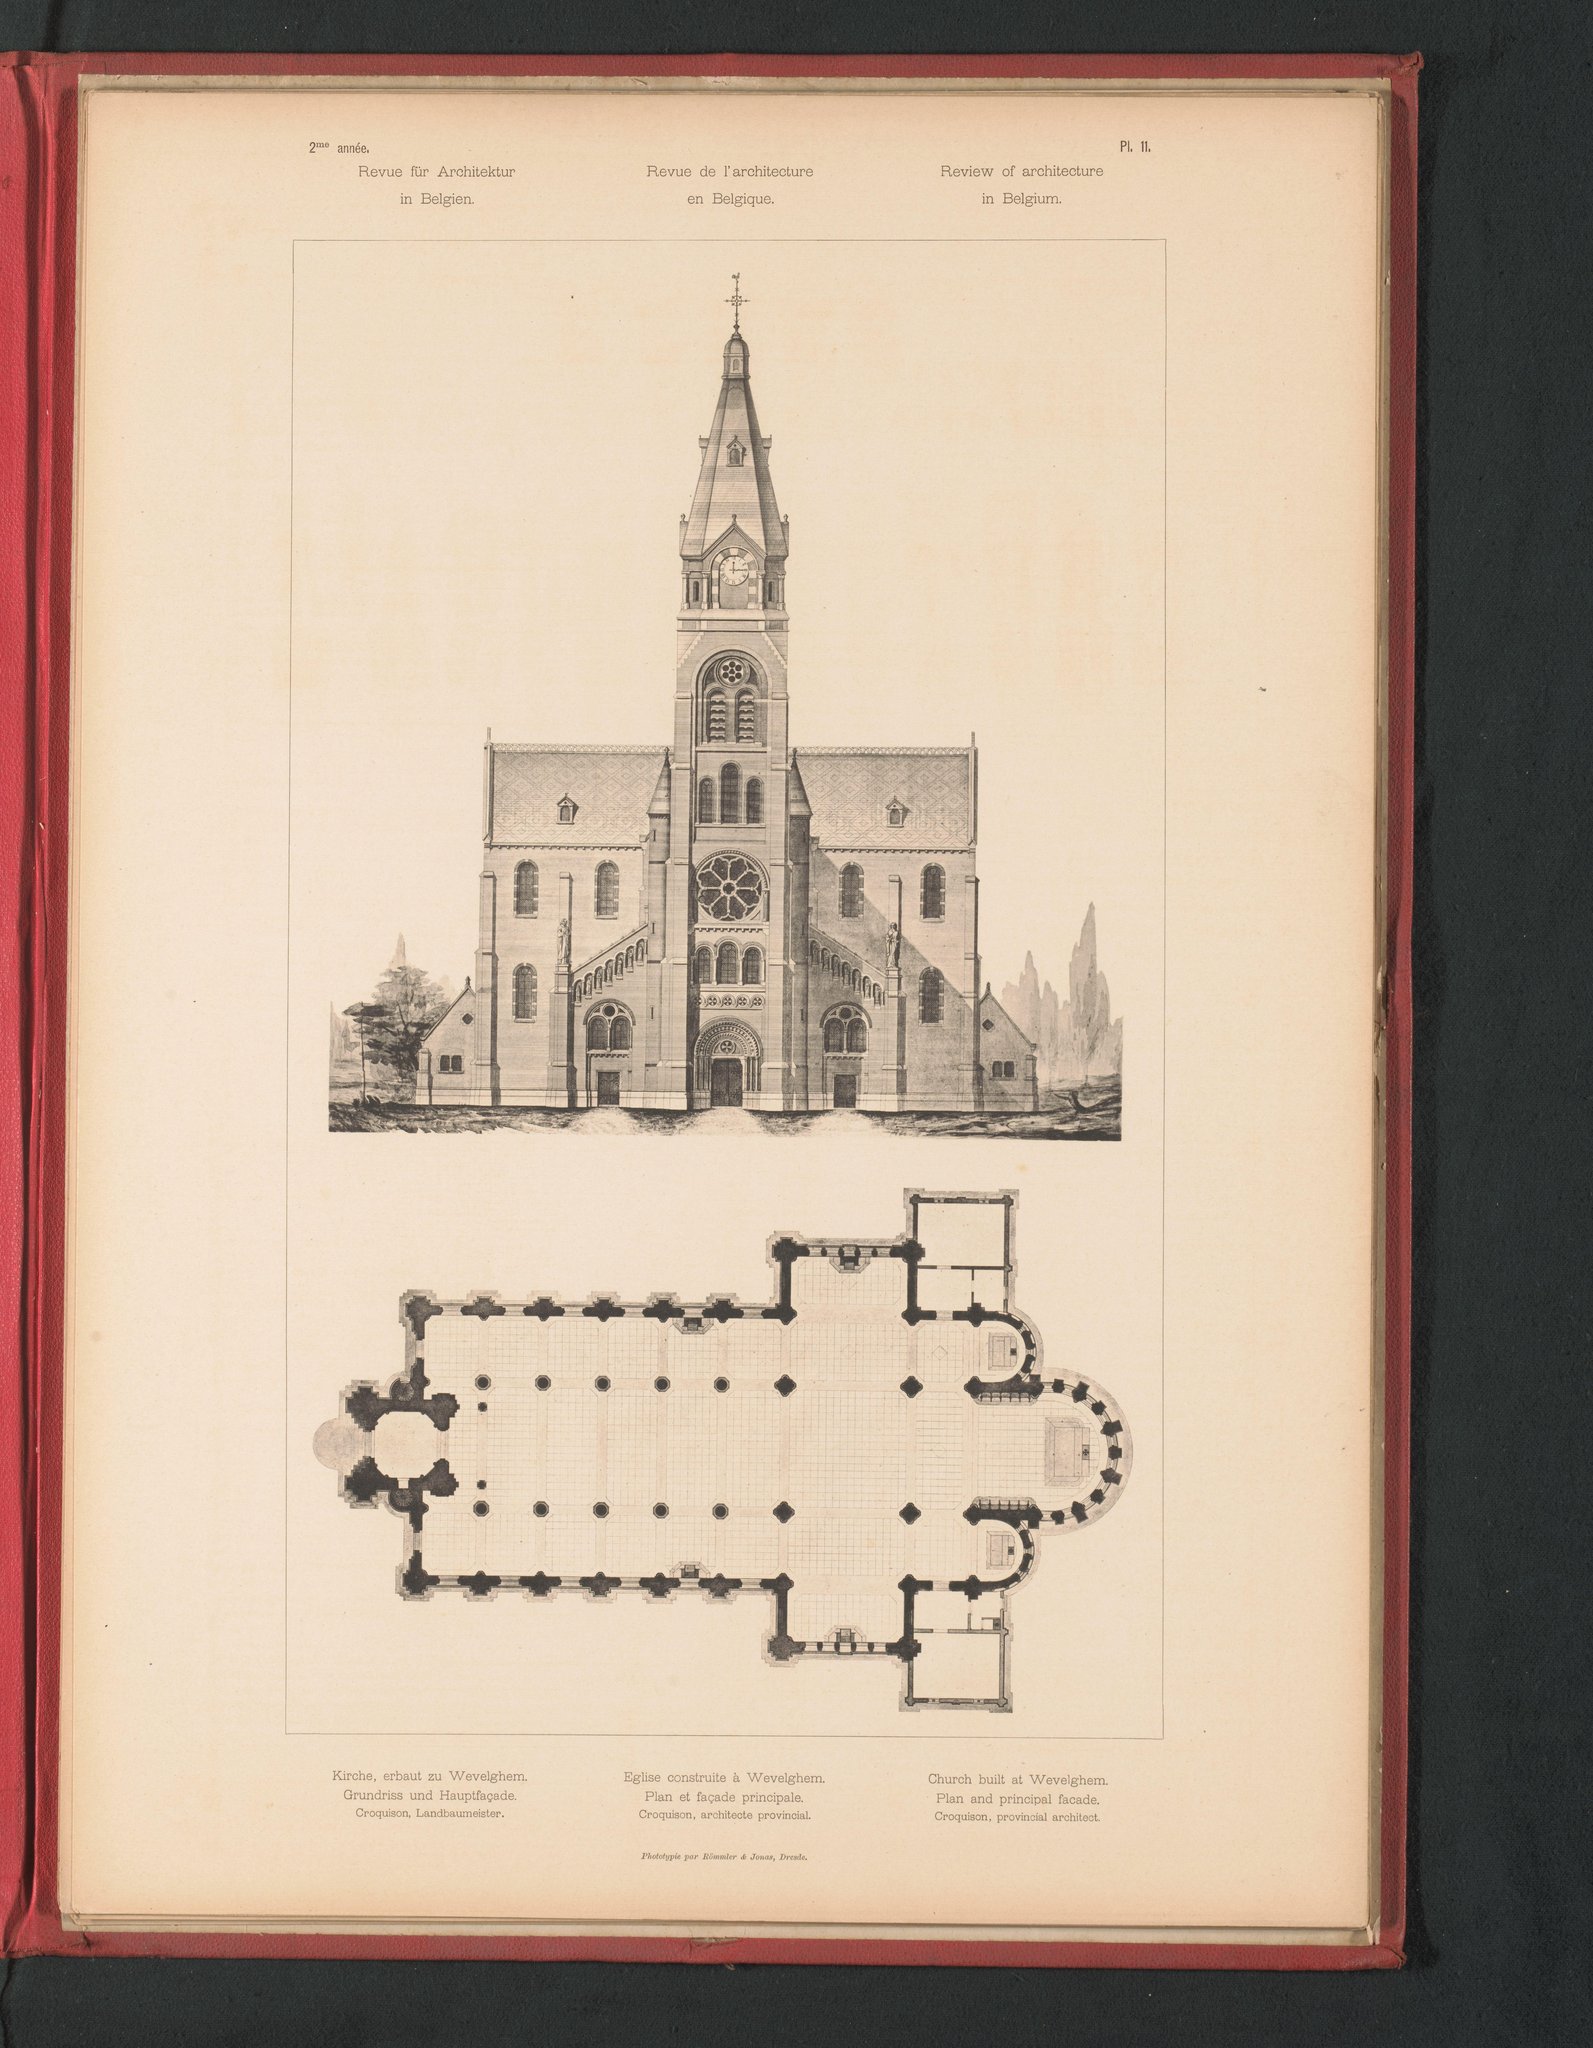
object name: reproduction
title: Revue für Architektur in Belgien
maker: pierre nicolas croquison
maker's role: architect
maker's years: 1806-1887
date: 1888-1893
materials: paper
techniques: photograph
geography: dresden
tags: church (exterior), plan ~ architecture, exterior ~ architectural design or model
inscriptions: inscription: ‘2me. année.’, number: ‘Pl. 11.’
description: Deze prenten maken deel uit van een omslag met 110 prenten op 90 bladen en 18 tekstbladen.